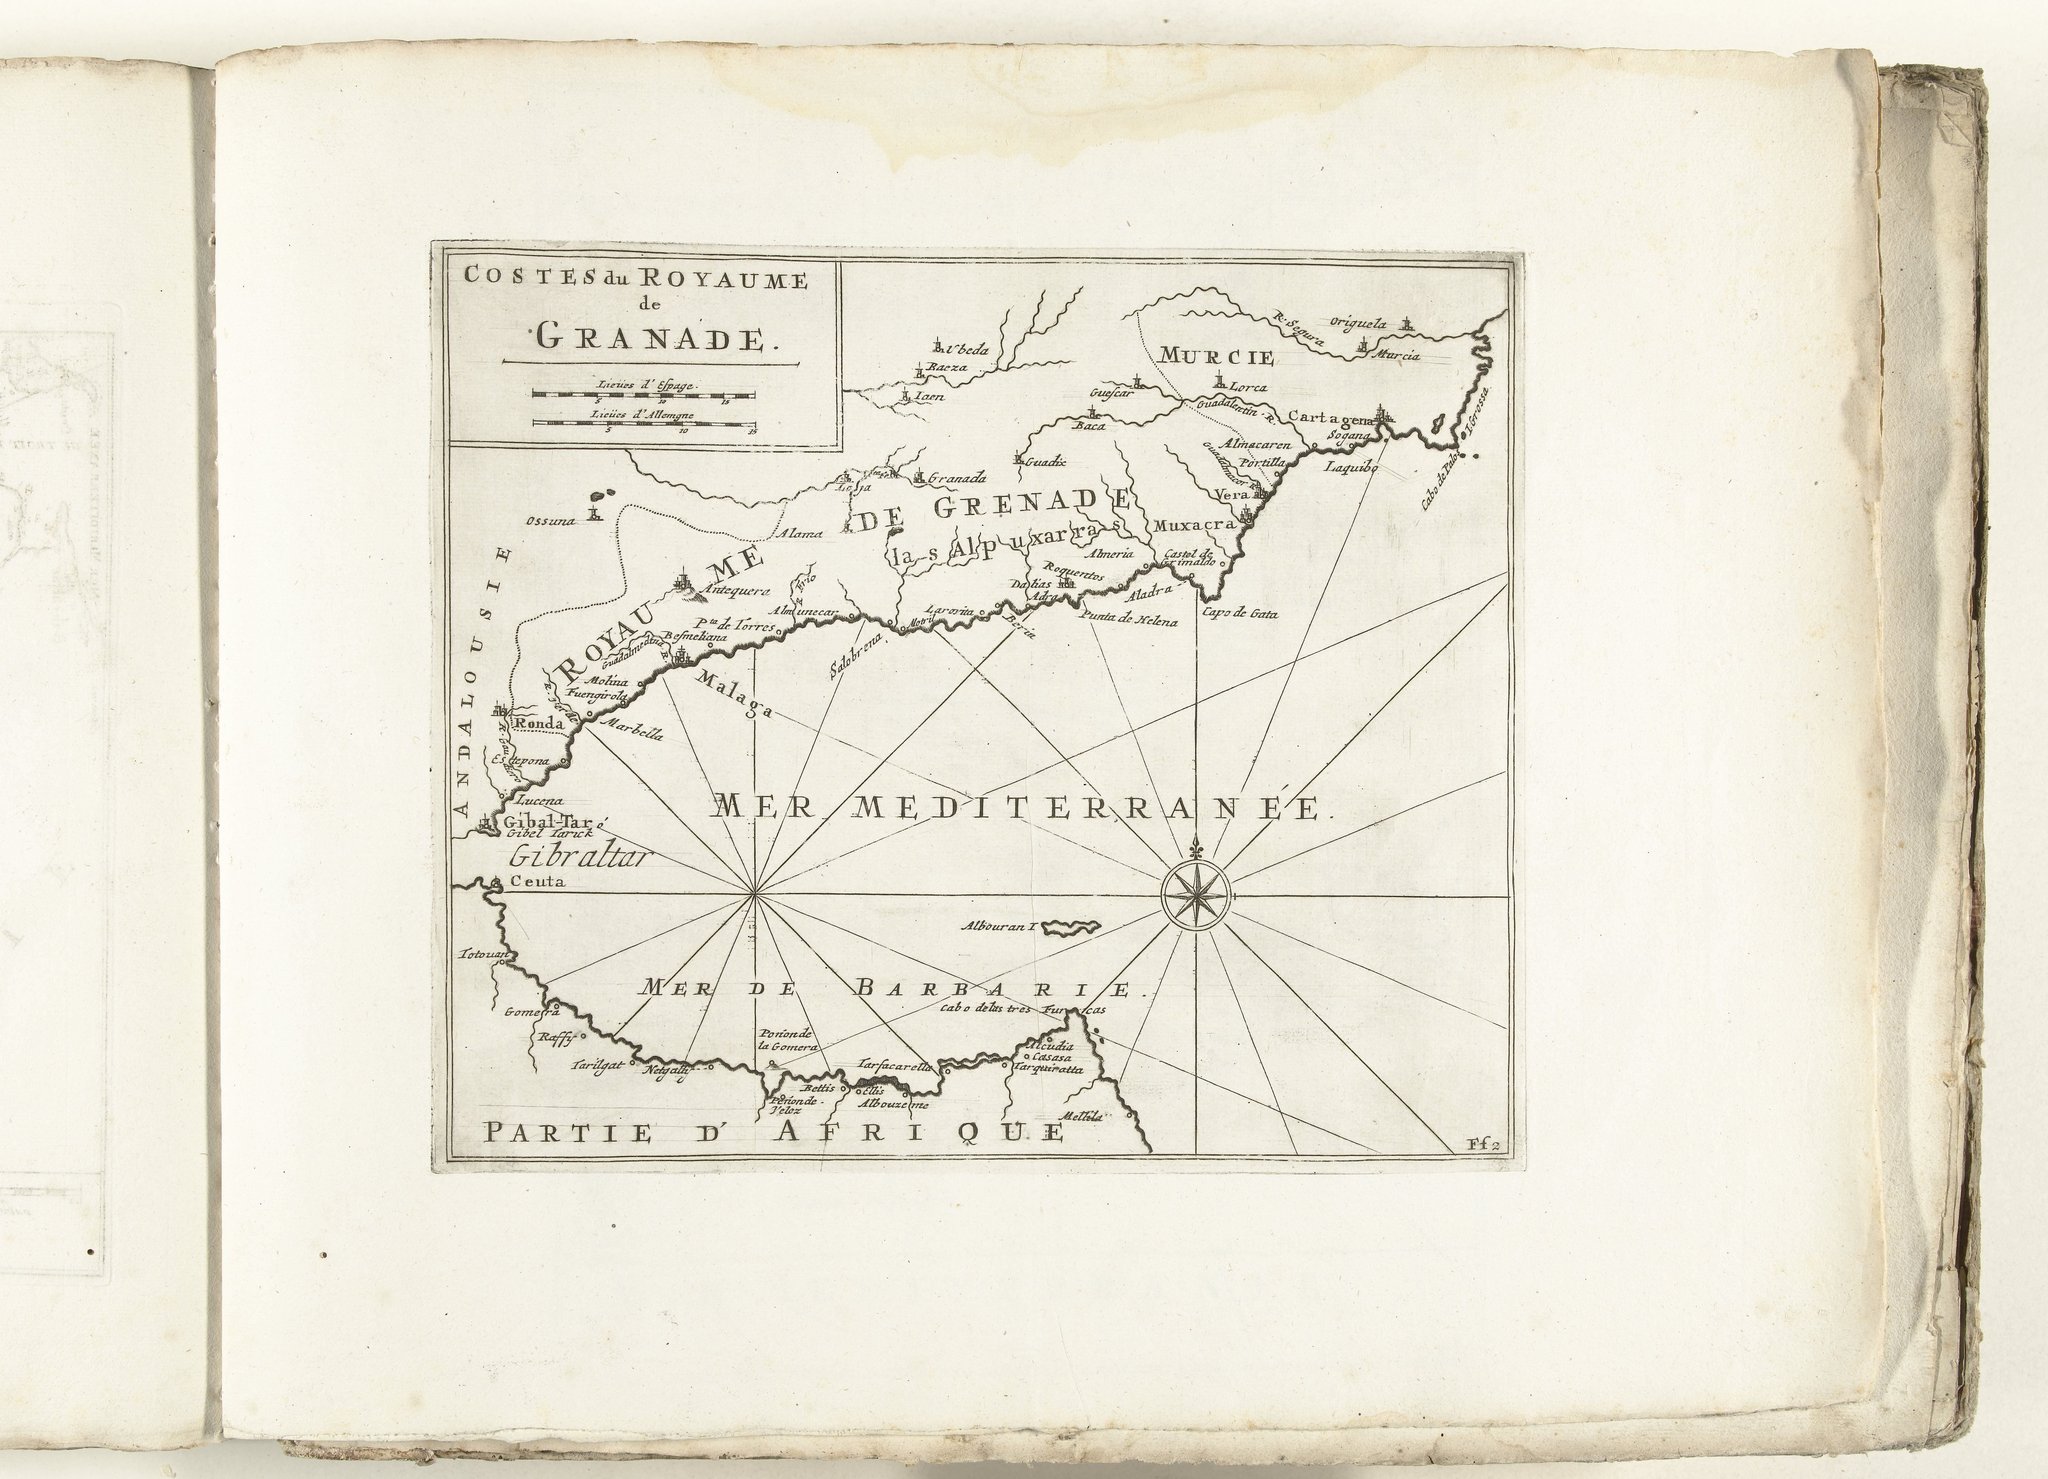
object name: print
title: Kaart van de Spaanse zuidkust bij Gibraltar, ca. 1702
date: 1702-1703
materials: paper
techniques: engraving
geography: amsterdam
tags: maps of separate countries or regions, spain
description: Kaart van de Spaanse zuidkust bij Gibraltar en een deel van de Noordafrikaanse kust. Gemerkt rechtsonder: Ff2. Onderdeel van het tweede van twee delen van het prentwerk: Les costes de France et d'Espagne (oftewel deel 14 van: Les Forces de l'Europe, Asie, Afrique et Amerique), uitgegeven ca. 1702. Het prentwerk bestaat in totaal uit 43 gemerkte platen van de kust van Frankrijk en Spanje, in het kader van de Spaanse Successieoorlog. Deze platen zijn gekopieerd naar anonieme Franse platen oorspronkelijk uitgegeven door Nicolas de Fer te Parijs. Titel en opschriften in de plaat in het Frans.